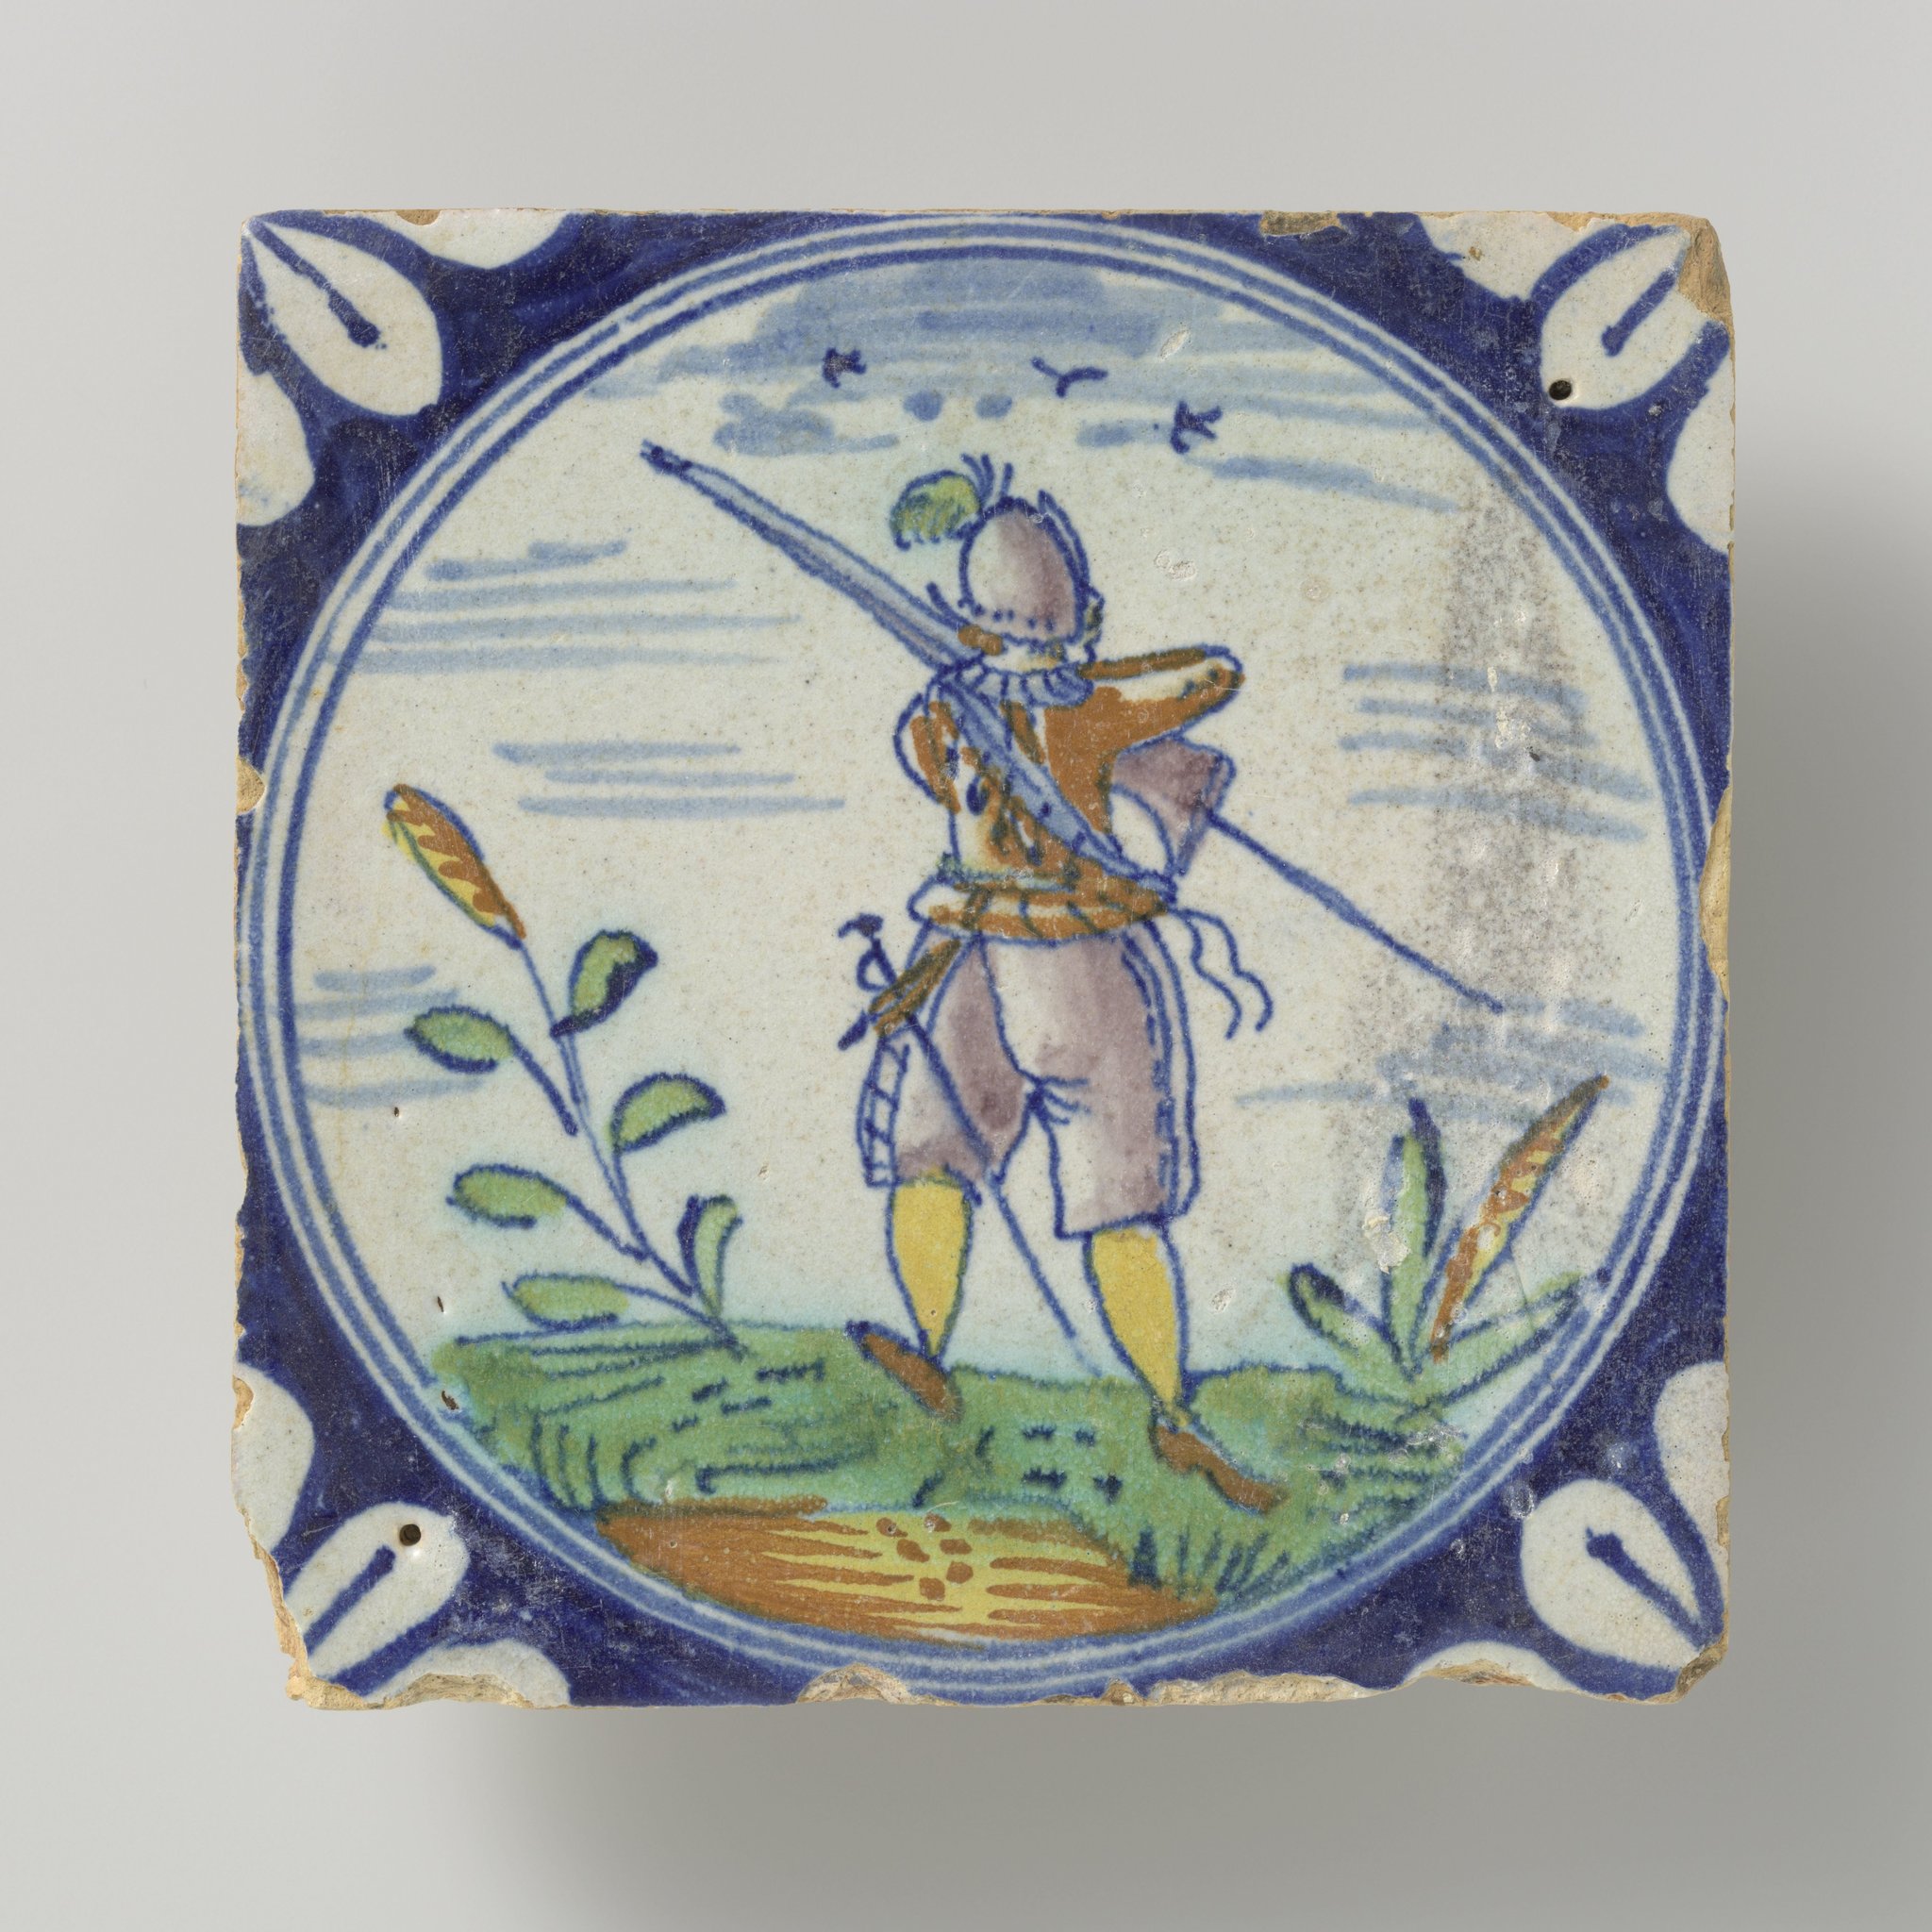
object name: tile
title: Tegel, veelkleurig beschilderd met een soldaat of een vaandeldrager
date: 1625-1700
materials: earthenware, glaze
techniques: maiolica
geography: netherlands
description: Tegel, veelkleurig beschilderd met een soldaat of een vaandeldrager.